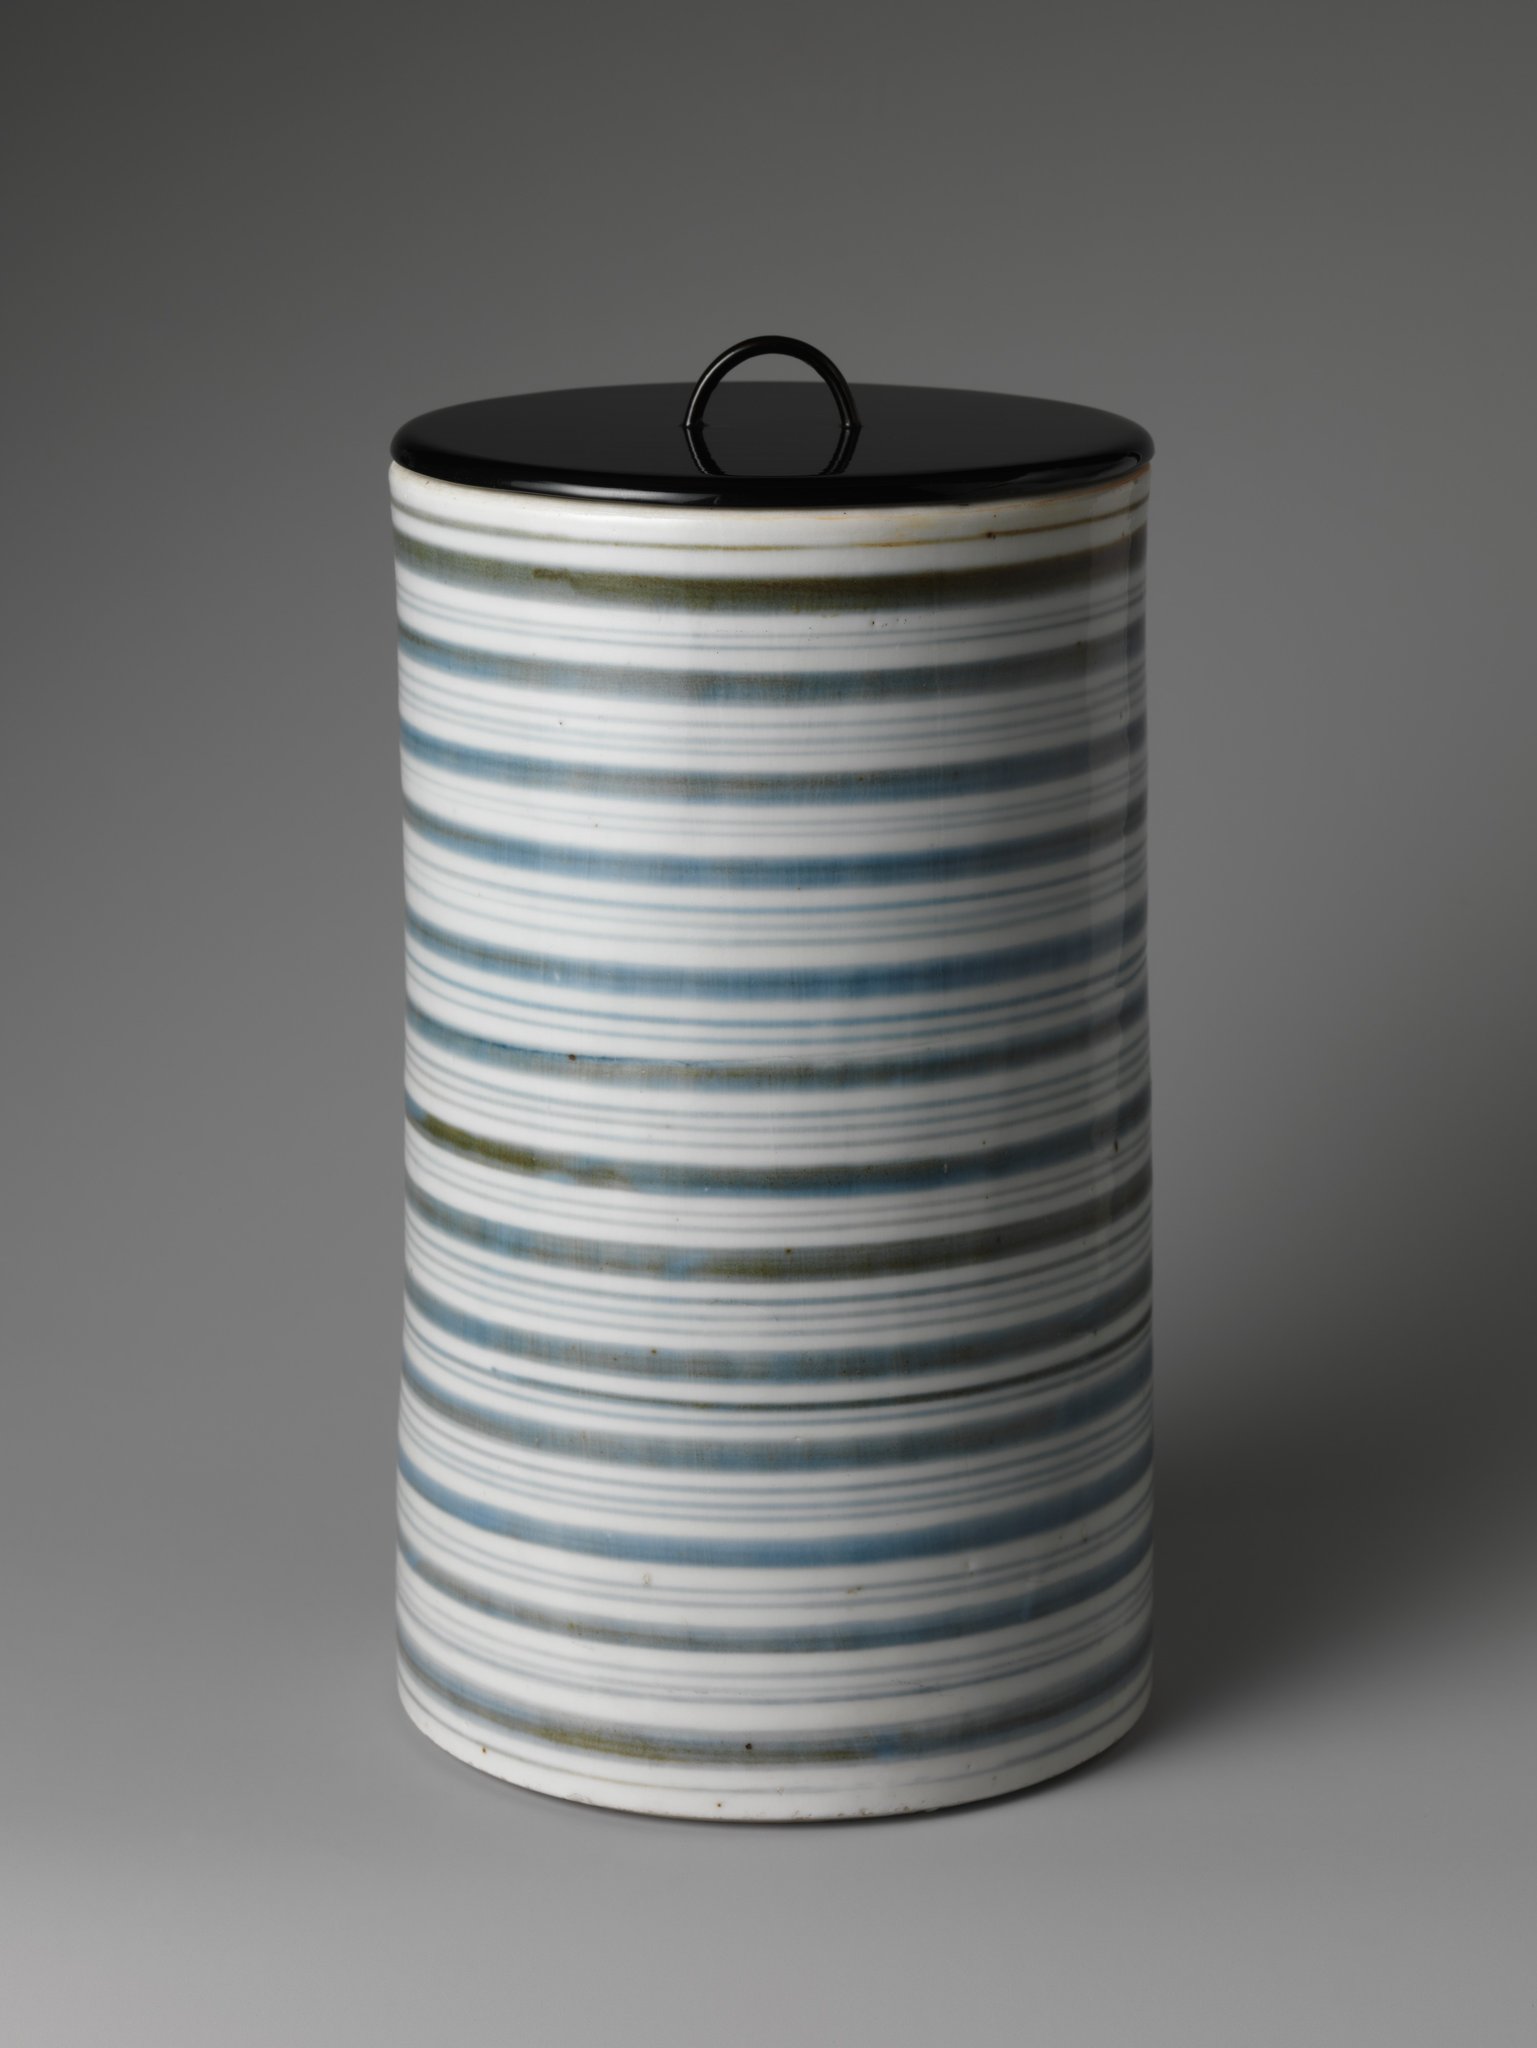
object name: water jar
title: Water Jar with Striped Design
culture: japanese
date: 1767-1800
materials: porcelain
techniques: underglaze